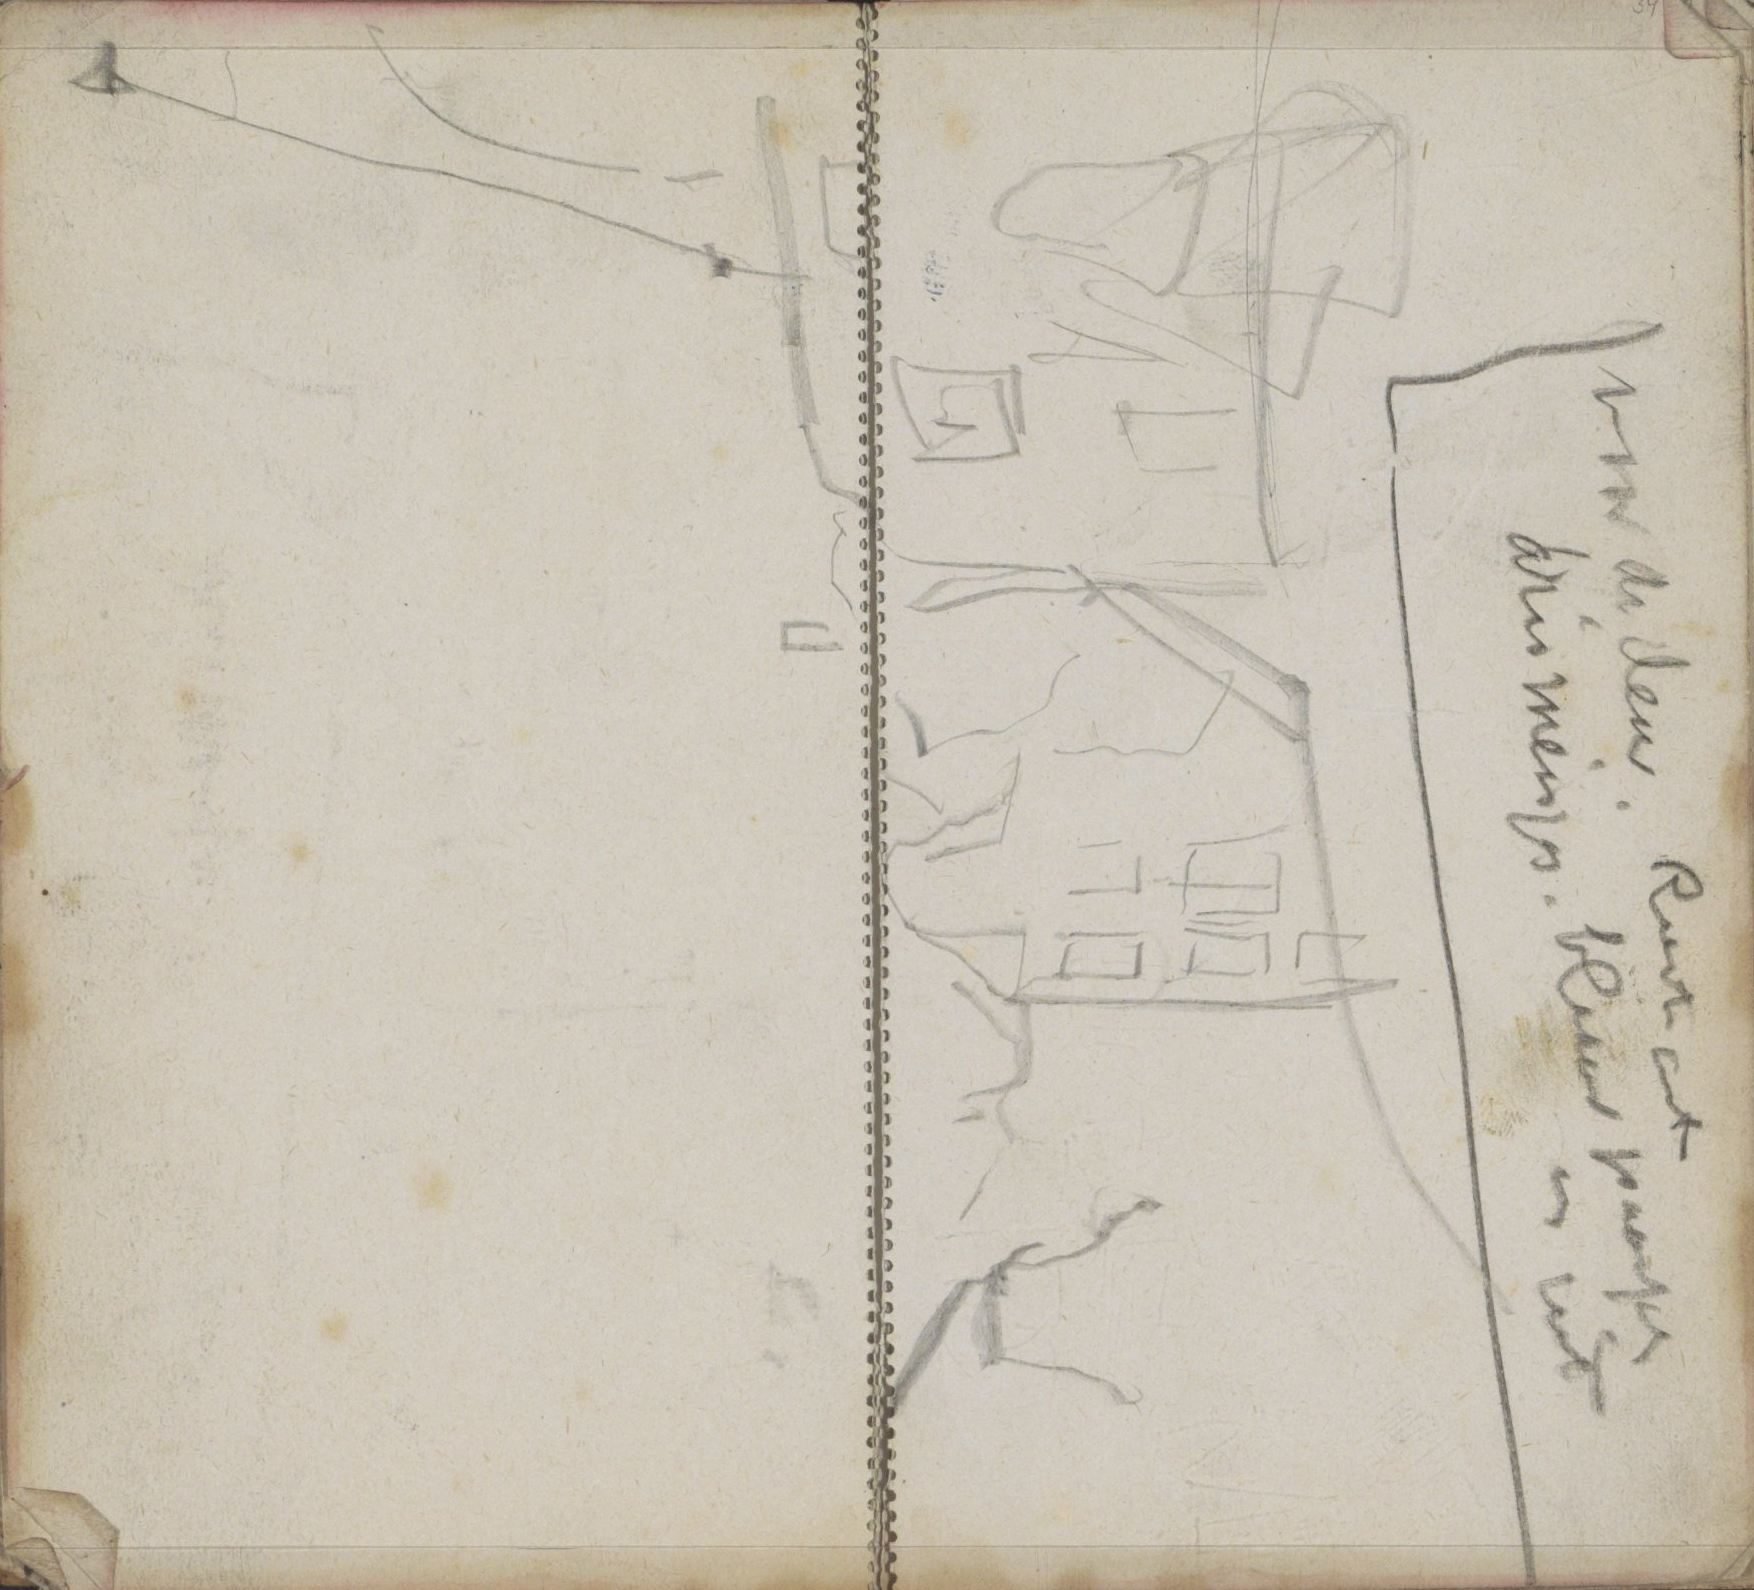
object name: sketchbook leaf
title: Gezicht op gebouwen in Amsterdam, mogelijk in de Reestraat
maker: george hendrik breitner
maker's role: draughtsman, painter, print maker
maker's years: 1857-1923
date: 1893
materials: paper, pencil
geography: amsterdam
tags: urban housing, street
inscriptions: annotation: ‘voor de deur. Reestraat/ drie meisjes’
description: Gezicht op gebouwen in Amsterdam, mogelijk in de Reestraat. Pagina 33 en pagina 34 uit een schetsboek met 22 bladen vervaardigd te Amsterdam.